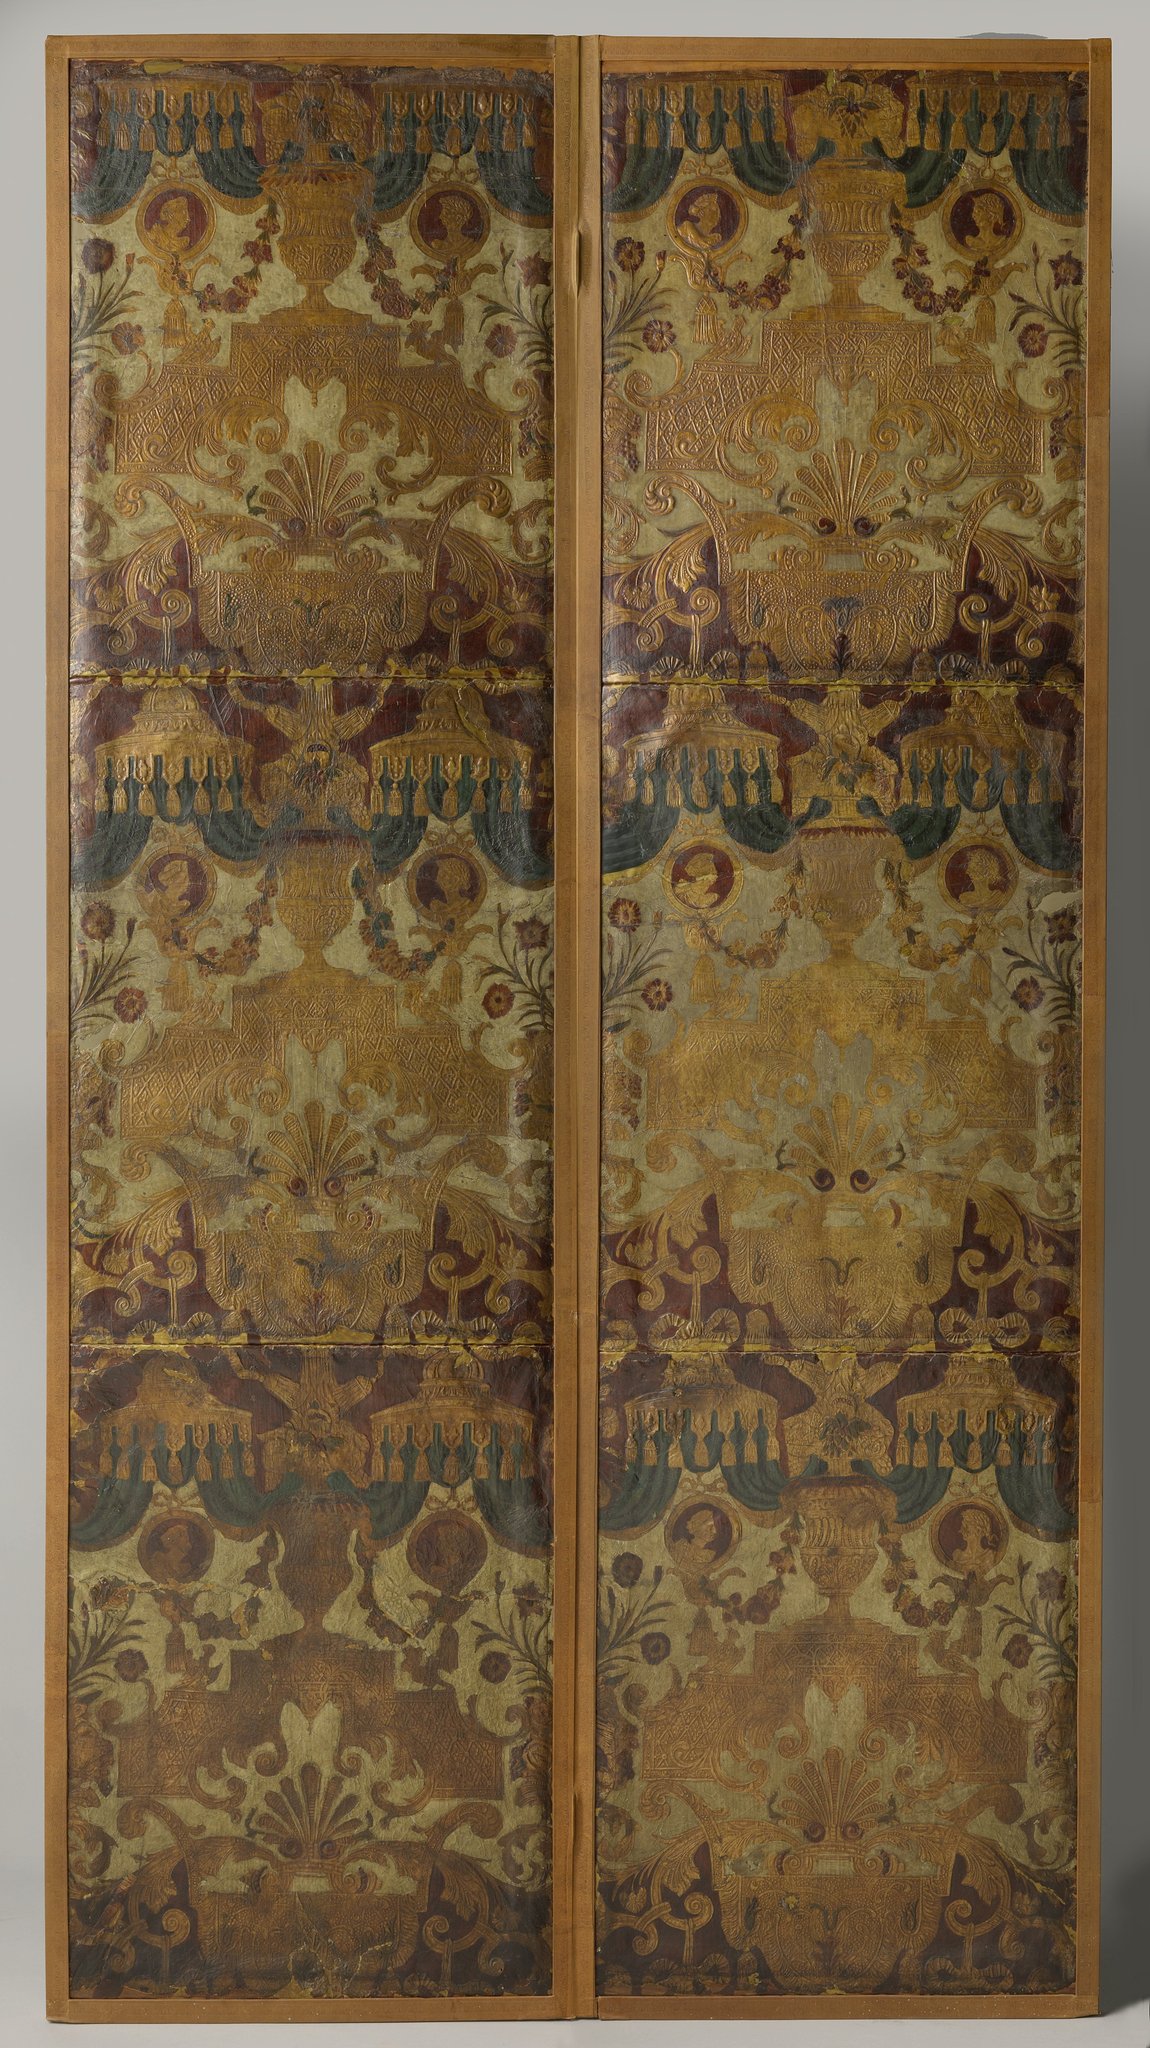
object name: screen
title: Kamerscherm, tweeslags, bekleed met tweemaal drie vellen verheven goudleer met een symmetrisch Lodewijk XIVe patroon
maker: Anonymous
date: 1700-1710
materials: gilt leather, wood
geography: northern netherlands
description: Kamerscherm, tweeslags, bekleed met tweemaal drie vellen verheven goudleer met een symmetrisch Lodewijk XIVe patroon met tuinvaas onder baldakijnen met antieke portretmedaillons, band- en servetwerk en een palmet. Beschildering in bruin-rood en groen op grijze grond.